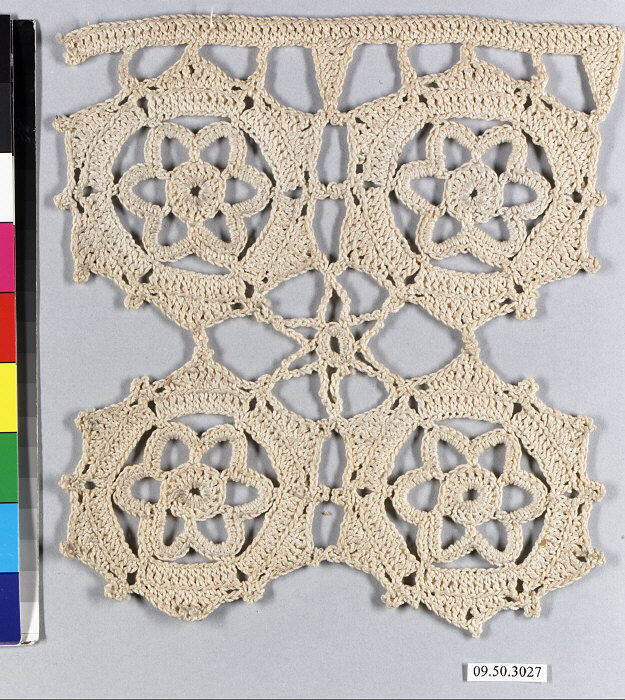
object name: sample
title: Crochet Work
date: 1801-1900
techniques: crochet